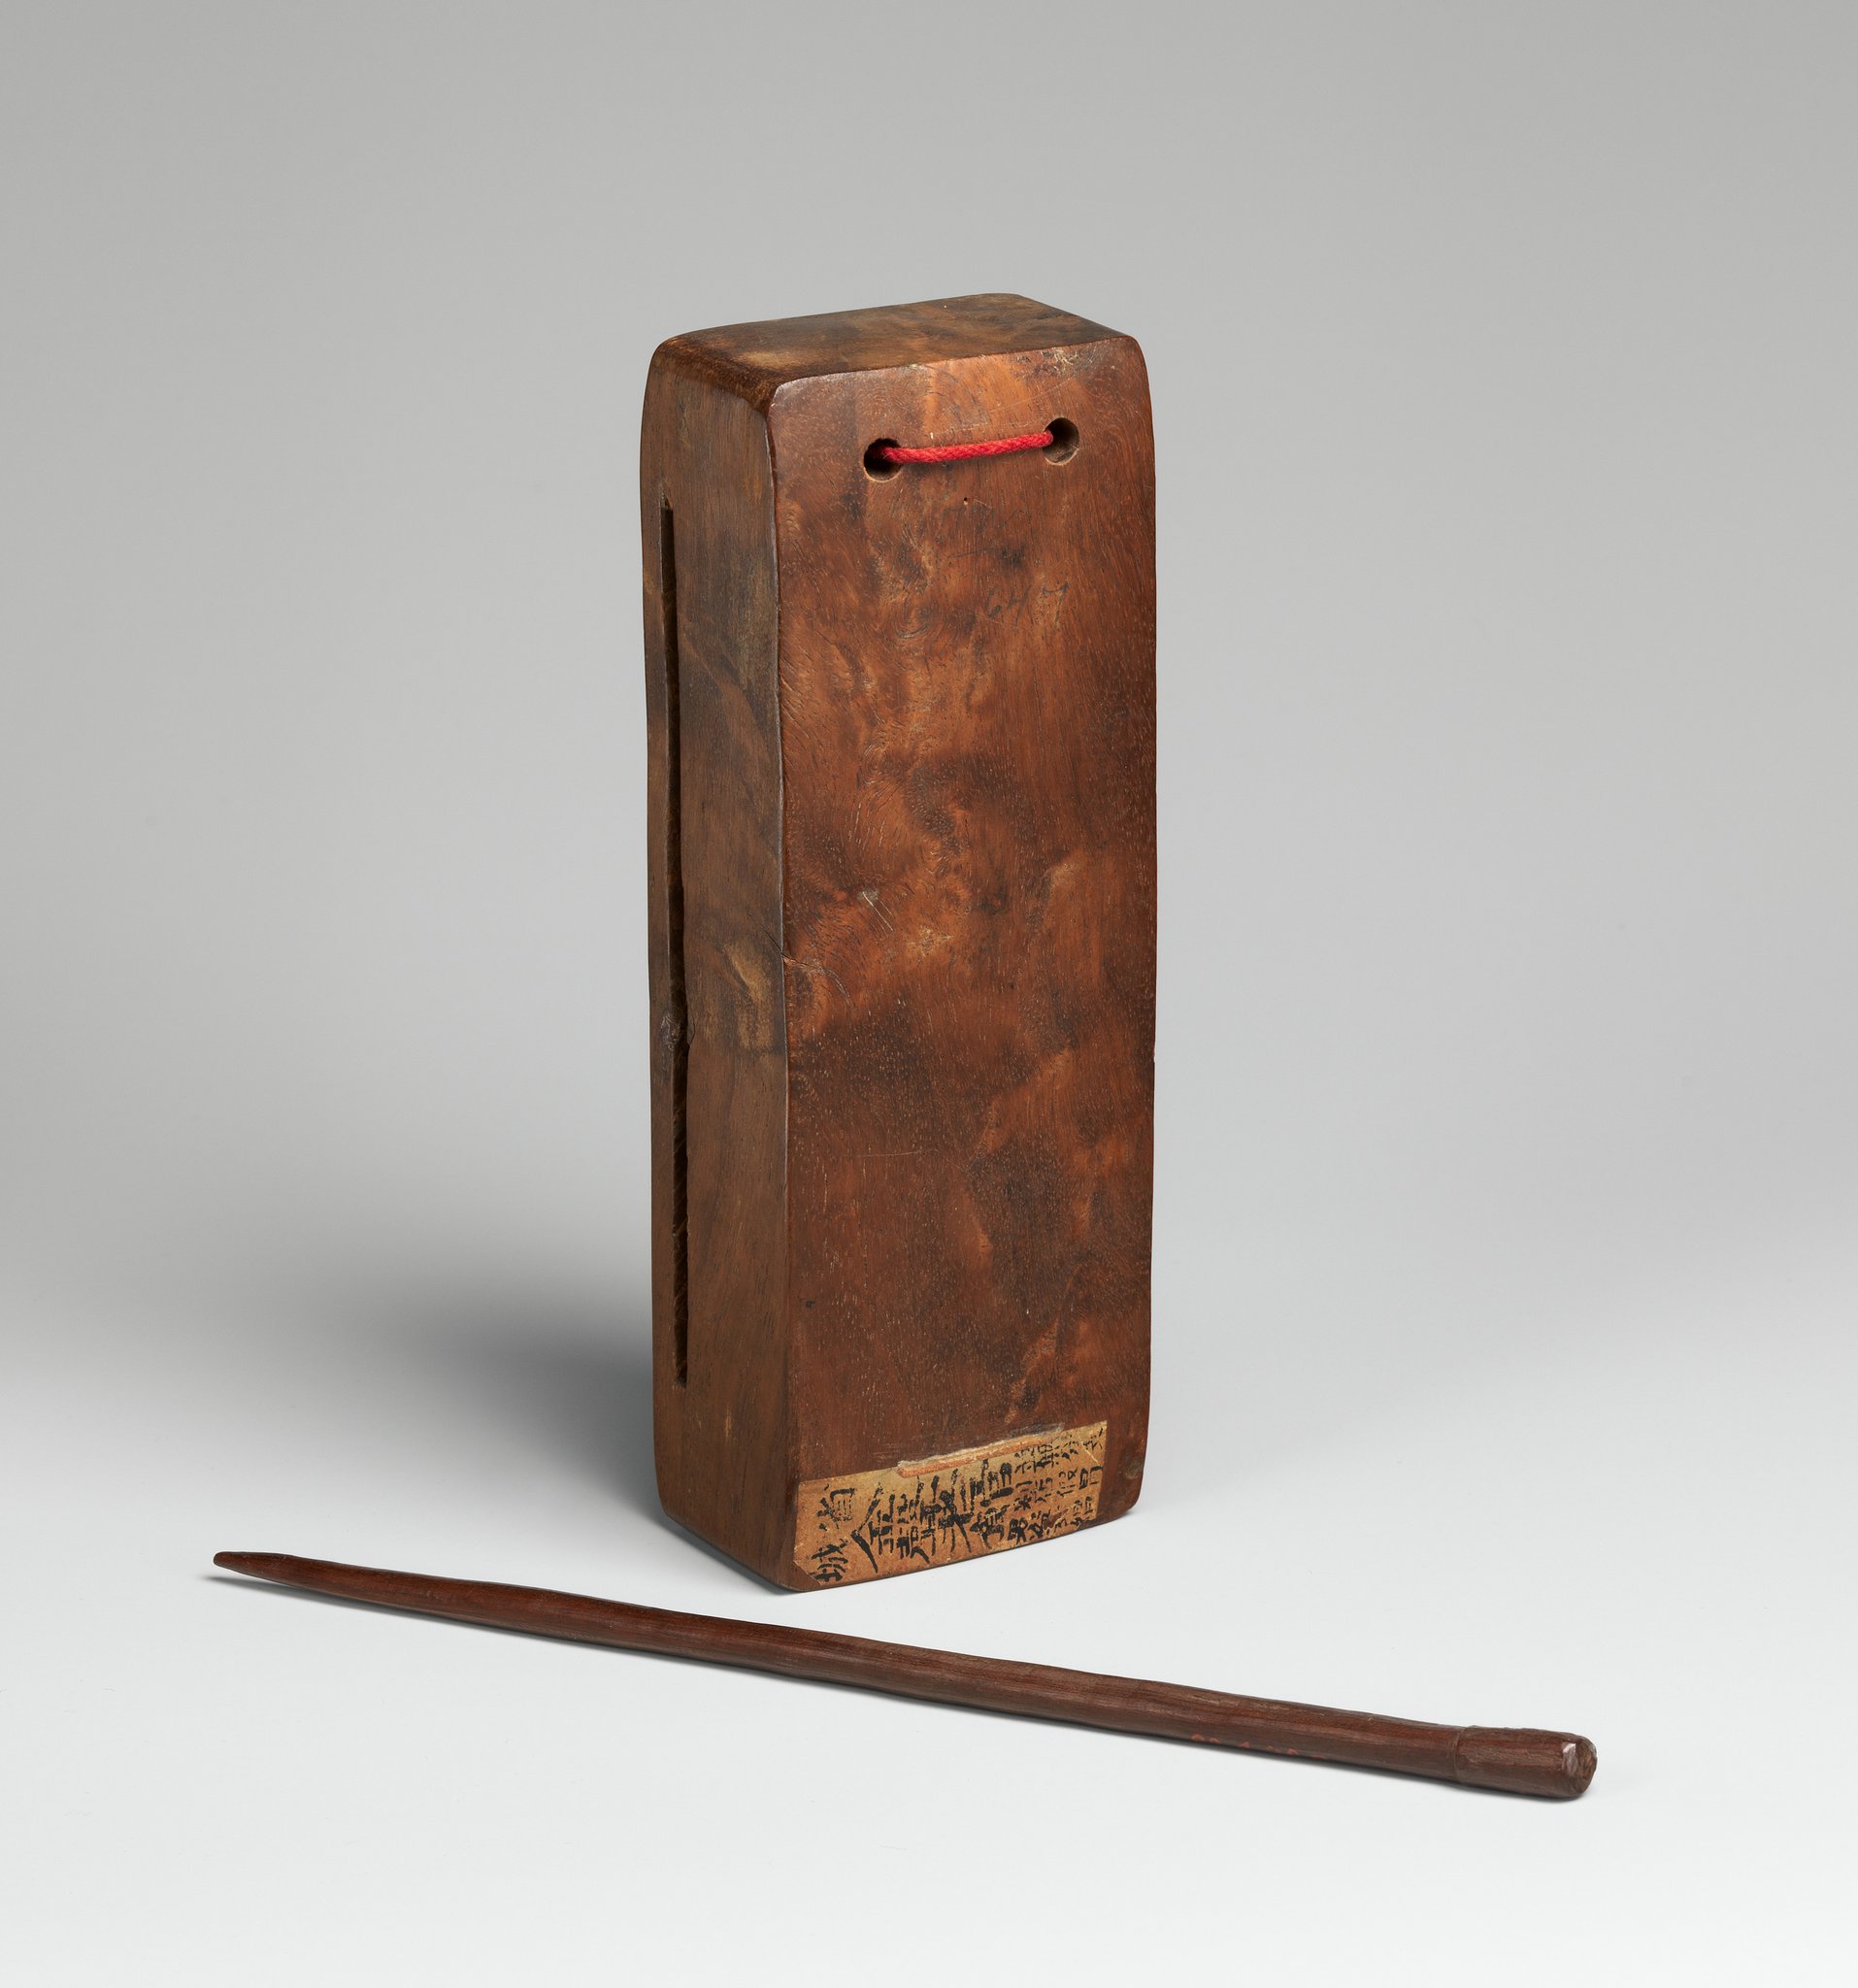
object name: nanbanzi wood block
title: Nanbanzi (南梆子)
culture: chinese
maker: golden tone workshop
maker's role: maker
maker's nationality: chinese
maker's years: 1800-1900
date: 1801-1900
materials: wood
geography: china